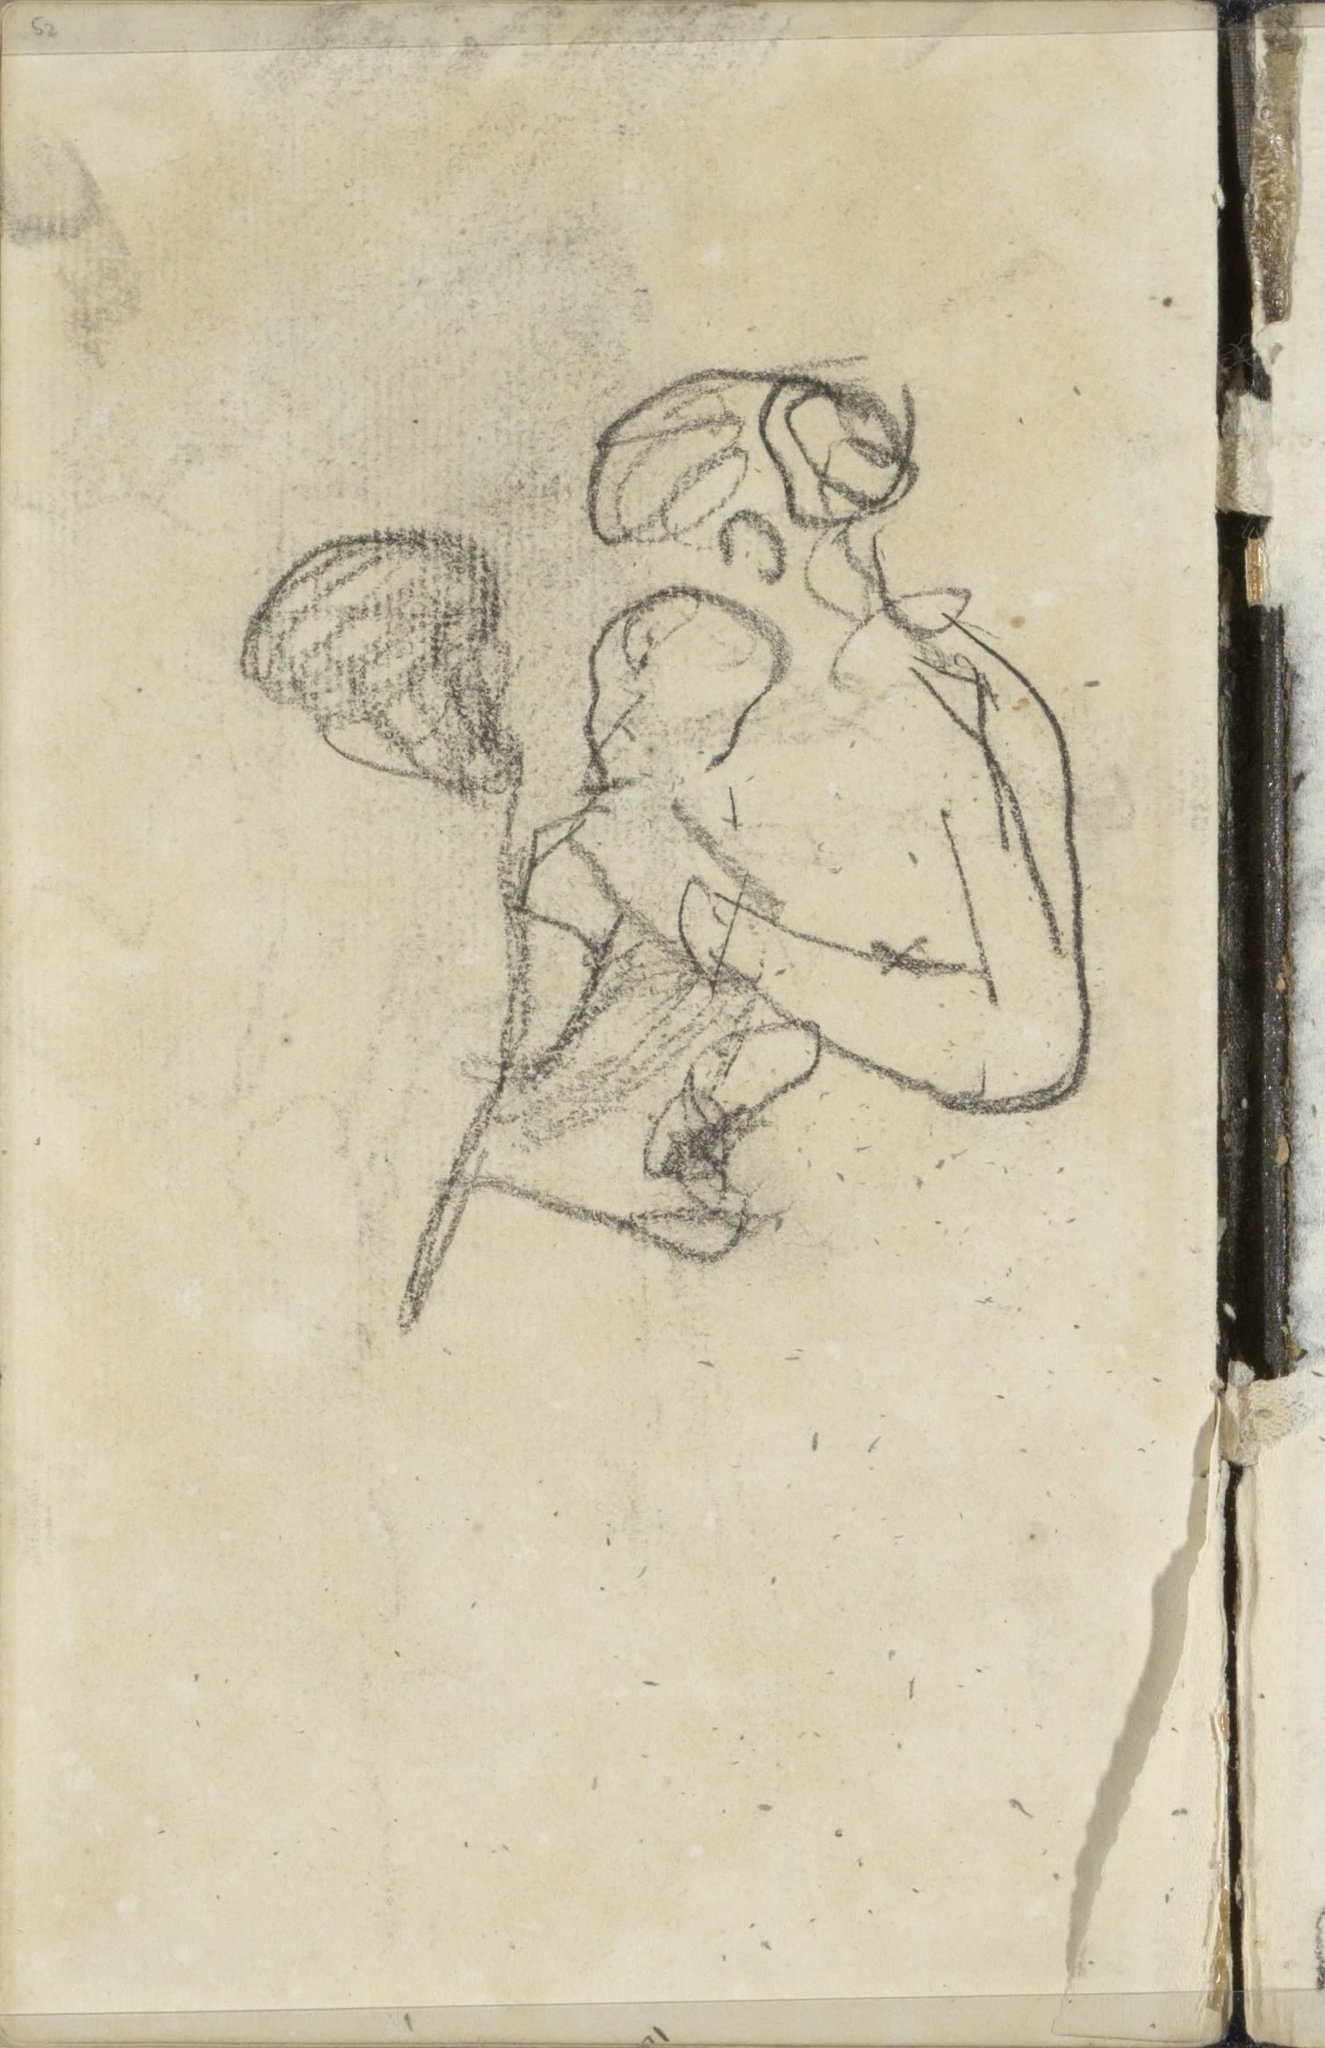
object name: sketchbook leaf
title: Vrouw met kind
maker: george hendrik breitner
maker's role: draughtsman, painter, print maker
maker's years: 1857-1923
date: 1880-1882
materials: chalk, paper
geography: the hague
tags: mother and child(ren), woman and child(ren) (family group)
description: Pagina 52 uit een schetsboek met 25 bladen.